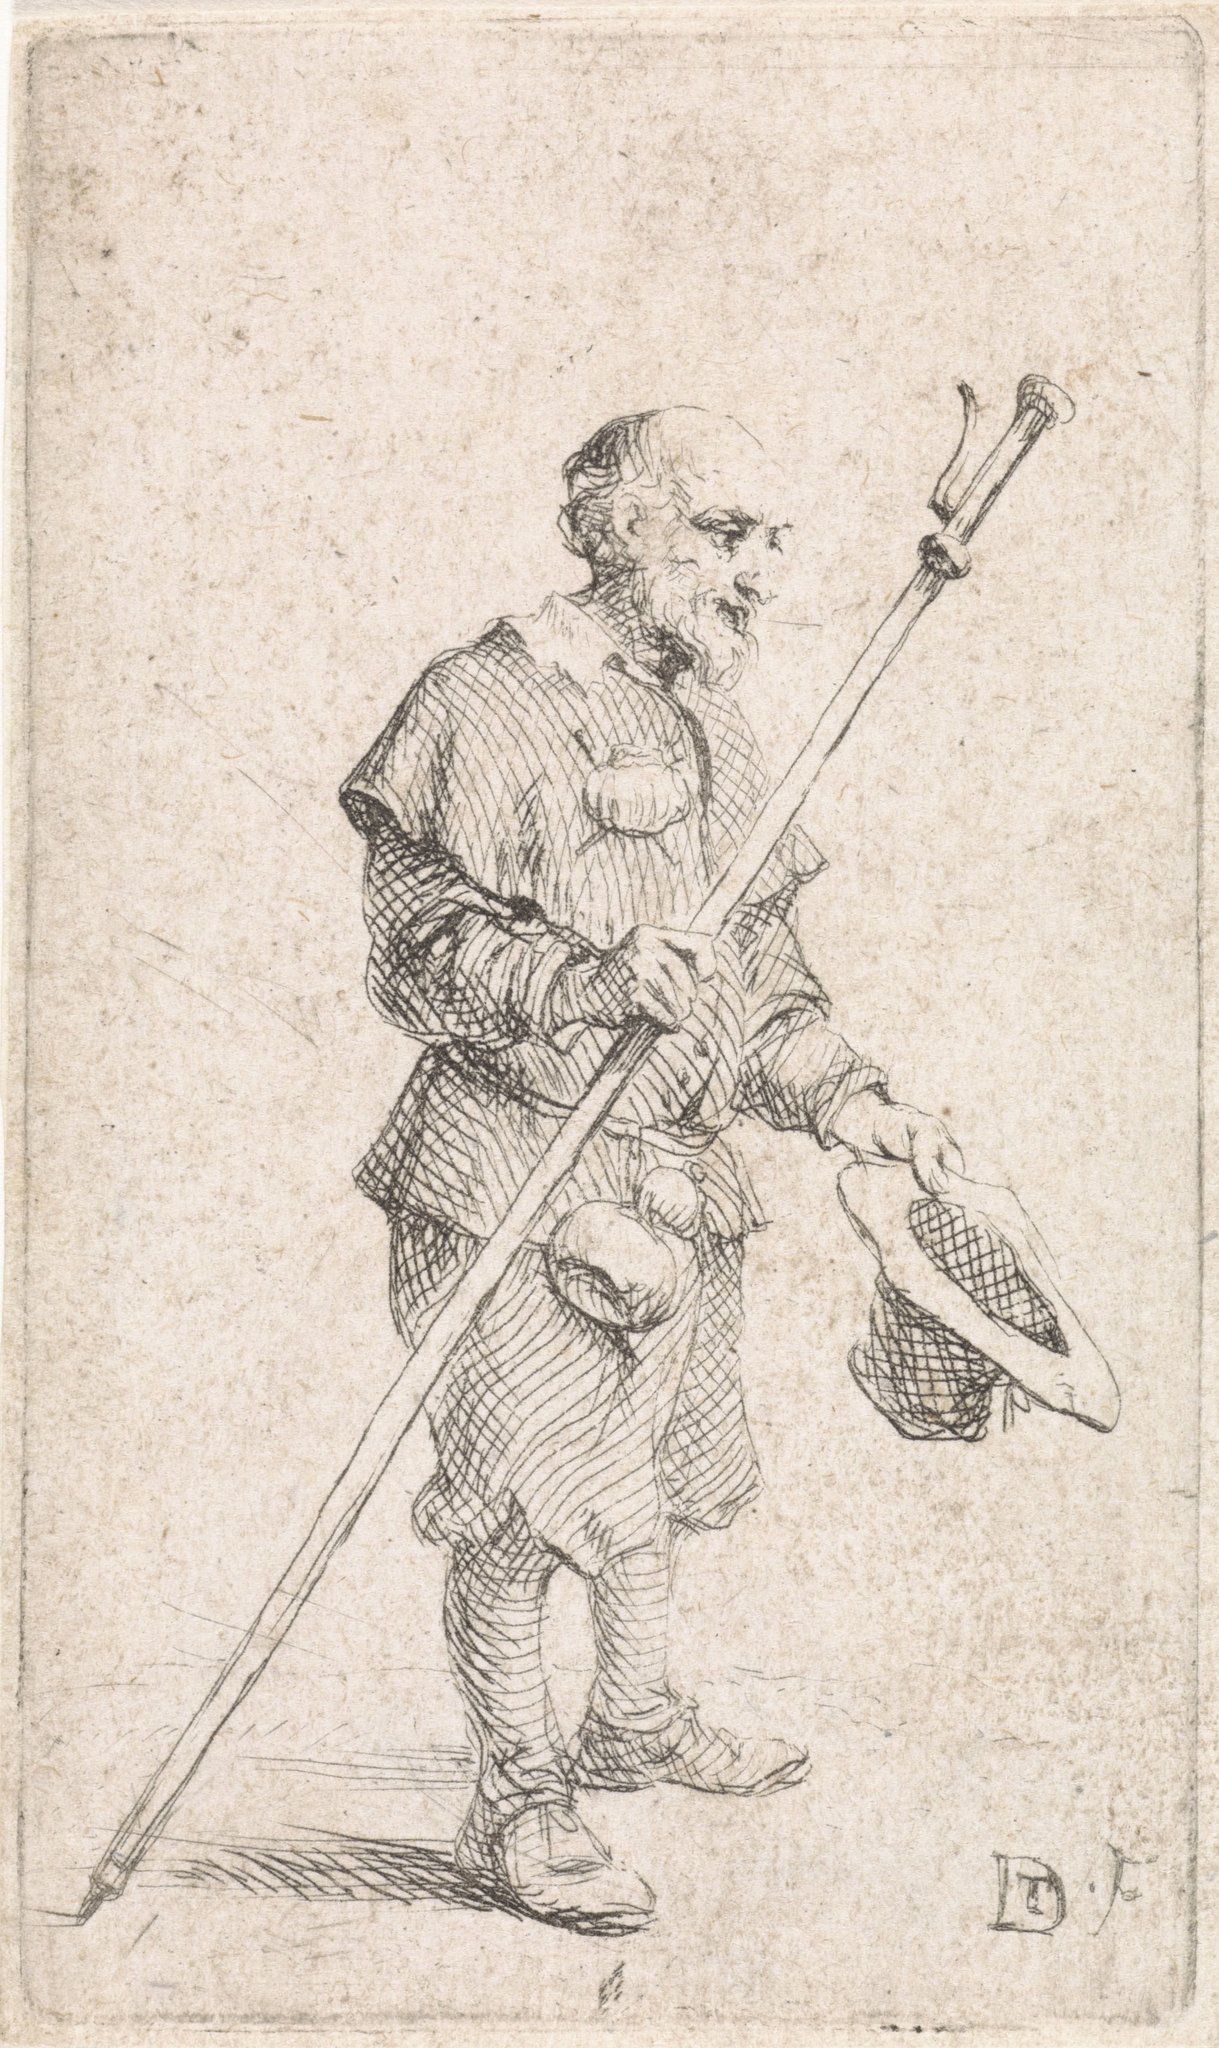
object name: print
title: Pelgrims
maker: david teniers (ii)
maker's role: draughtsman, painter, print maker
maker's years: 1610-1690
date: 1626-1690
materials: paper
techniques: etching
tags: pilgrim(s)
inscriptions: collector's mark: Lugt 2228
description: Een pelgrim met een hoed in de linker- en een staf in de rechterhand. Op zijn mantel een Jacobsschelp.